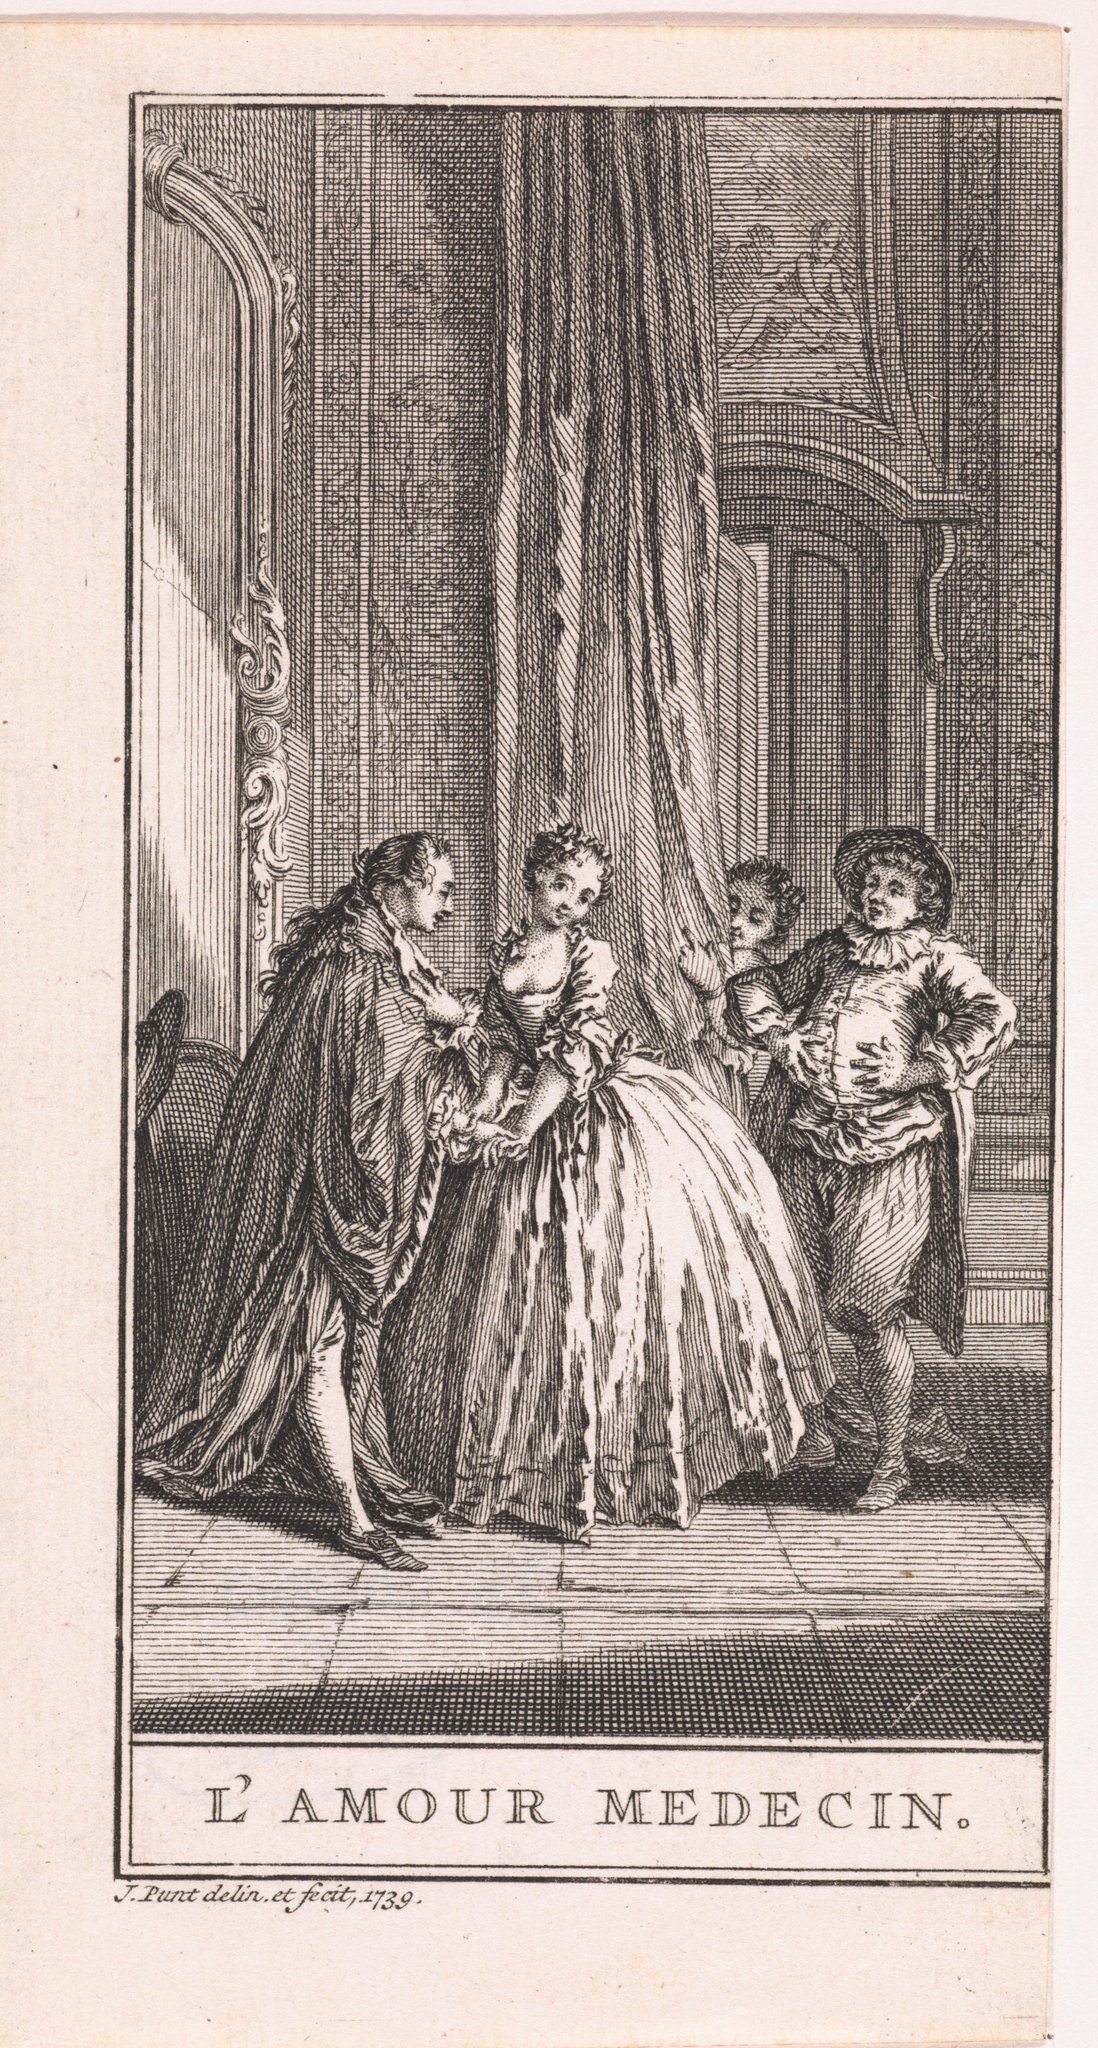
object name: book illustration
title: L'Amour Medecin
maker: jan punt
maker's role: draughtsman, print maker, publisher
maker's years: 1711-1779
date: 1739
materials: paper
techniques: engraving, etching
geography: amsterdam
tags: (moliere) specific works of literature (with author, title), couple of lovers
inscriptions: collector's mark: Lugt 2228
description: Een man verklaart de liefde aan een jonge vrouw en pakt haar bij de hand. Een man kijkt toe, met zijn handen op zijn dikke buik. Scène uit het toneelstuk L'Amour médecin, van Molière.